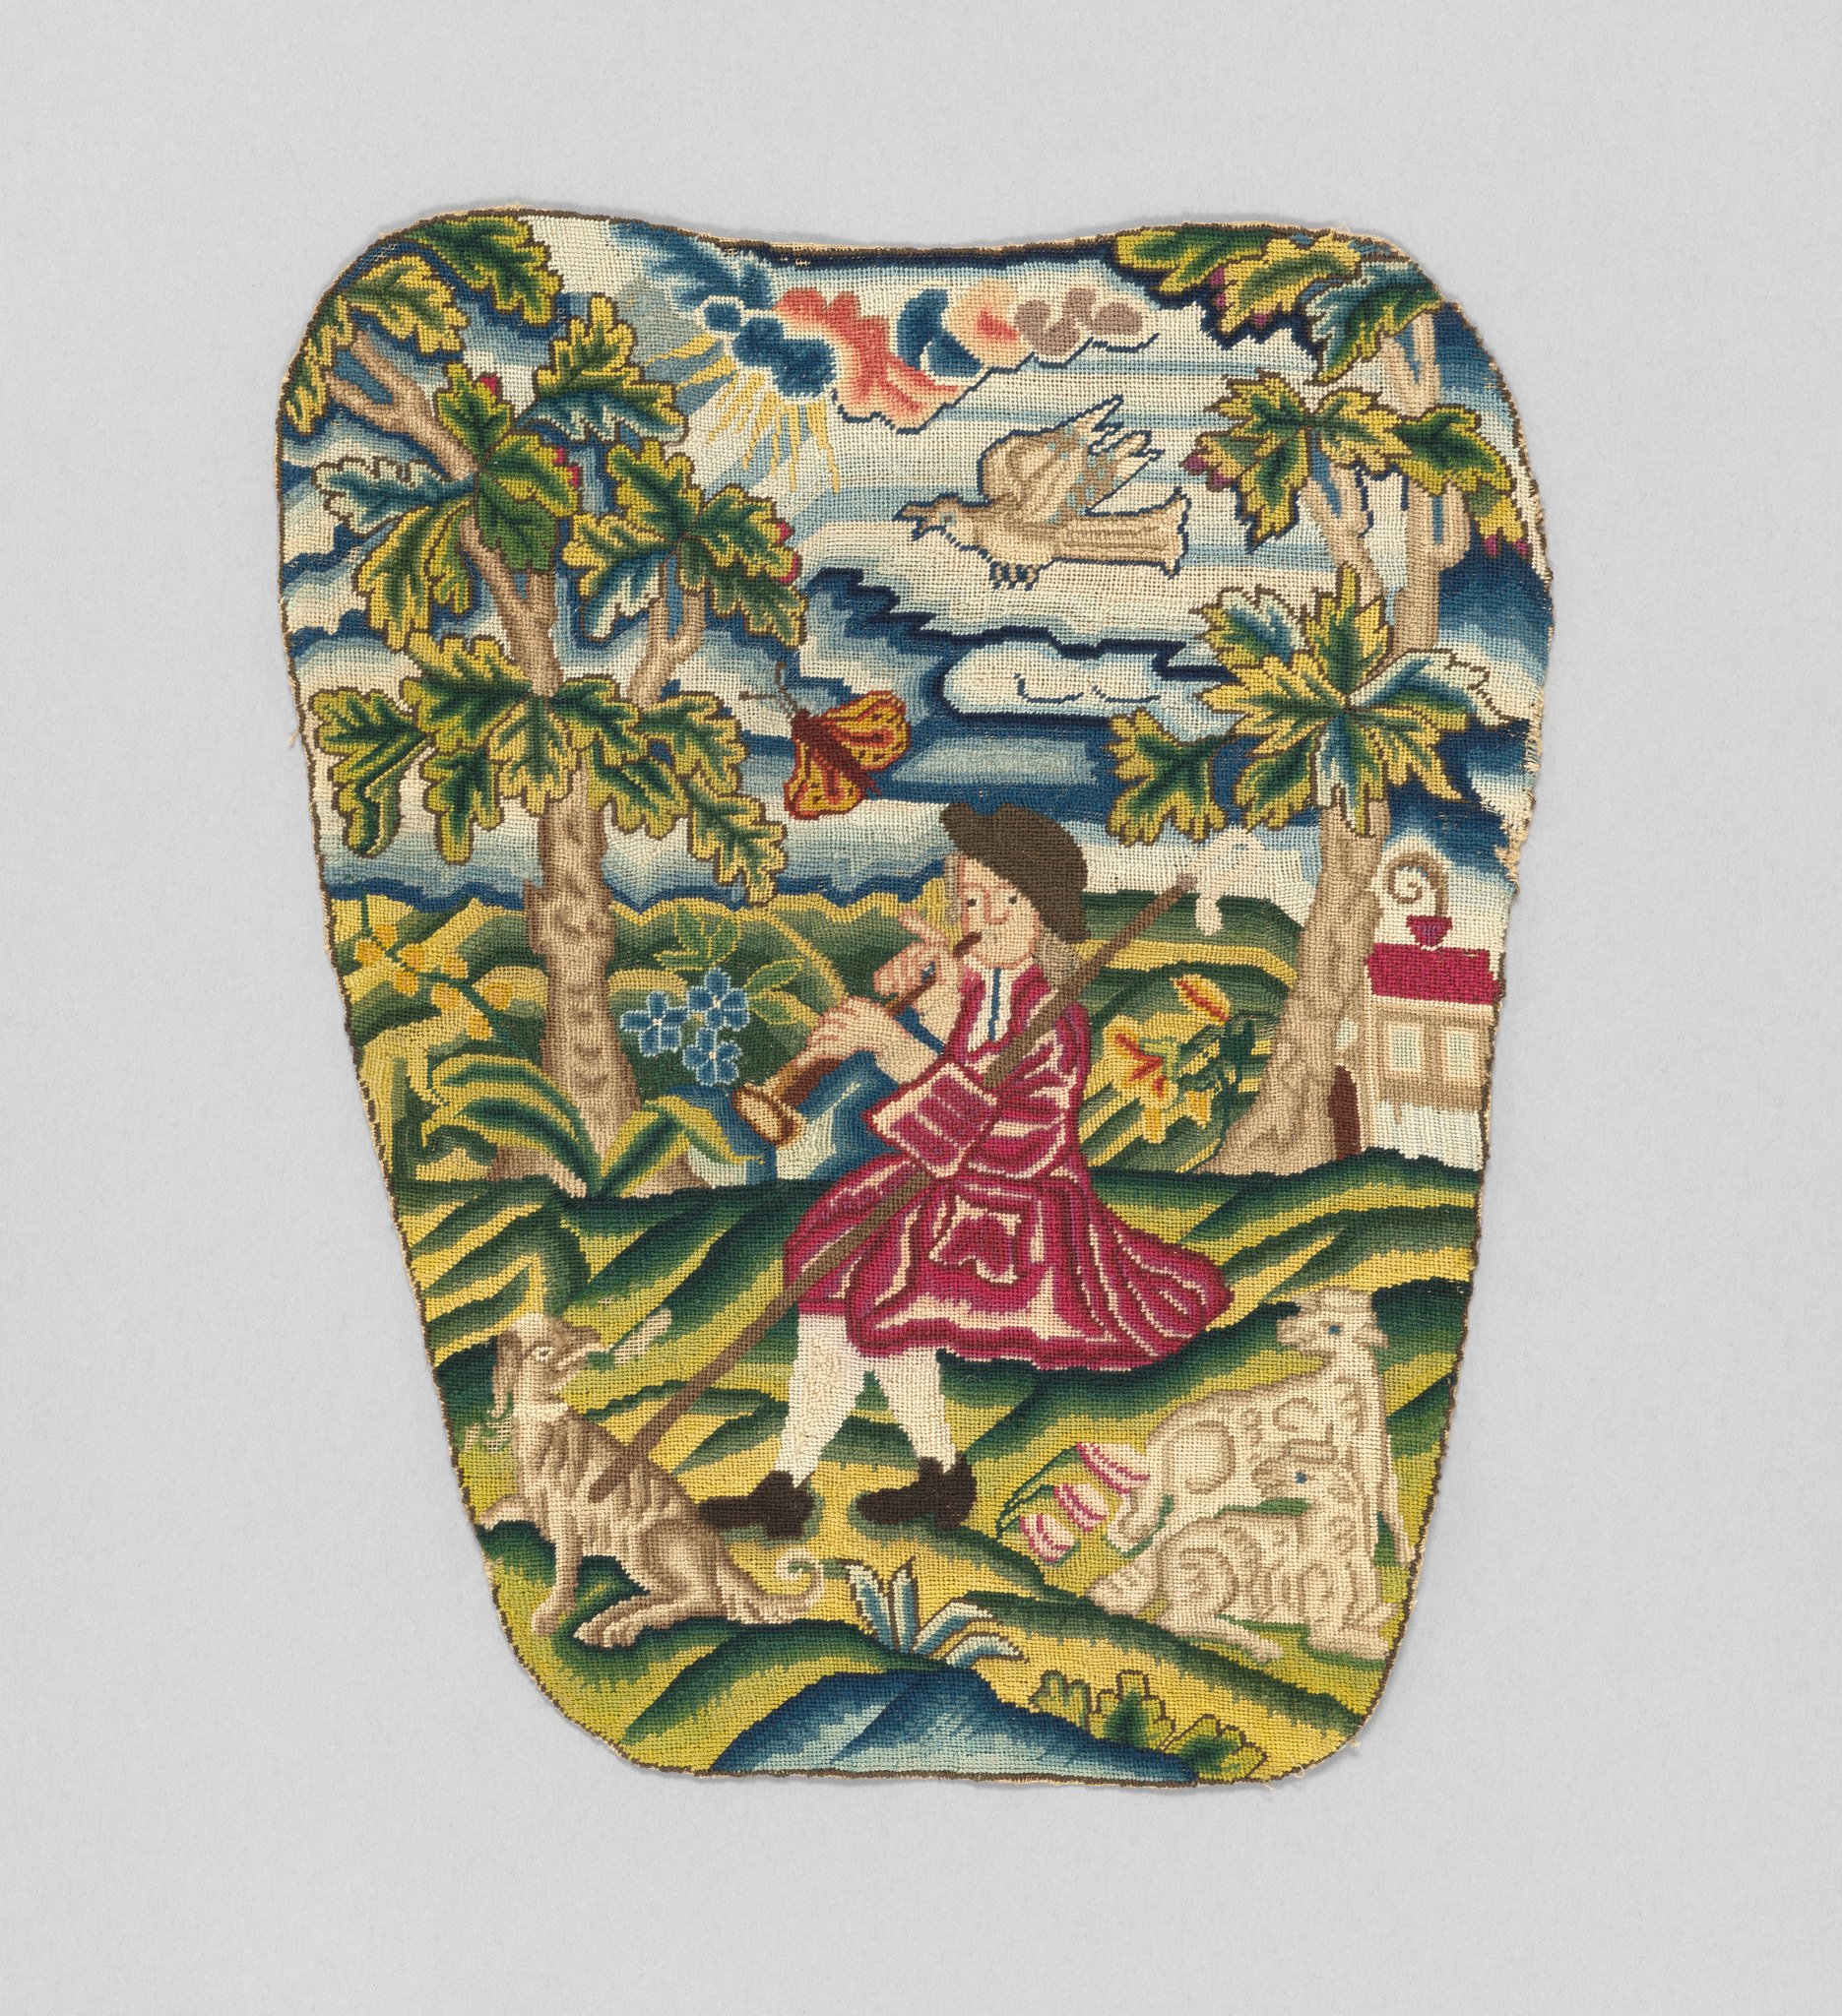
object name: hand screen panel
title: Panel for a hand screen (one of a pair)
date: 1701-1750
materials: canvas, wool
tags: musical instruments,birds,men,dogs,sheep,trees,shepherds